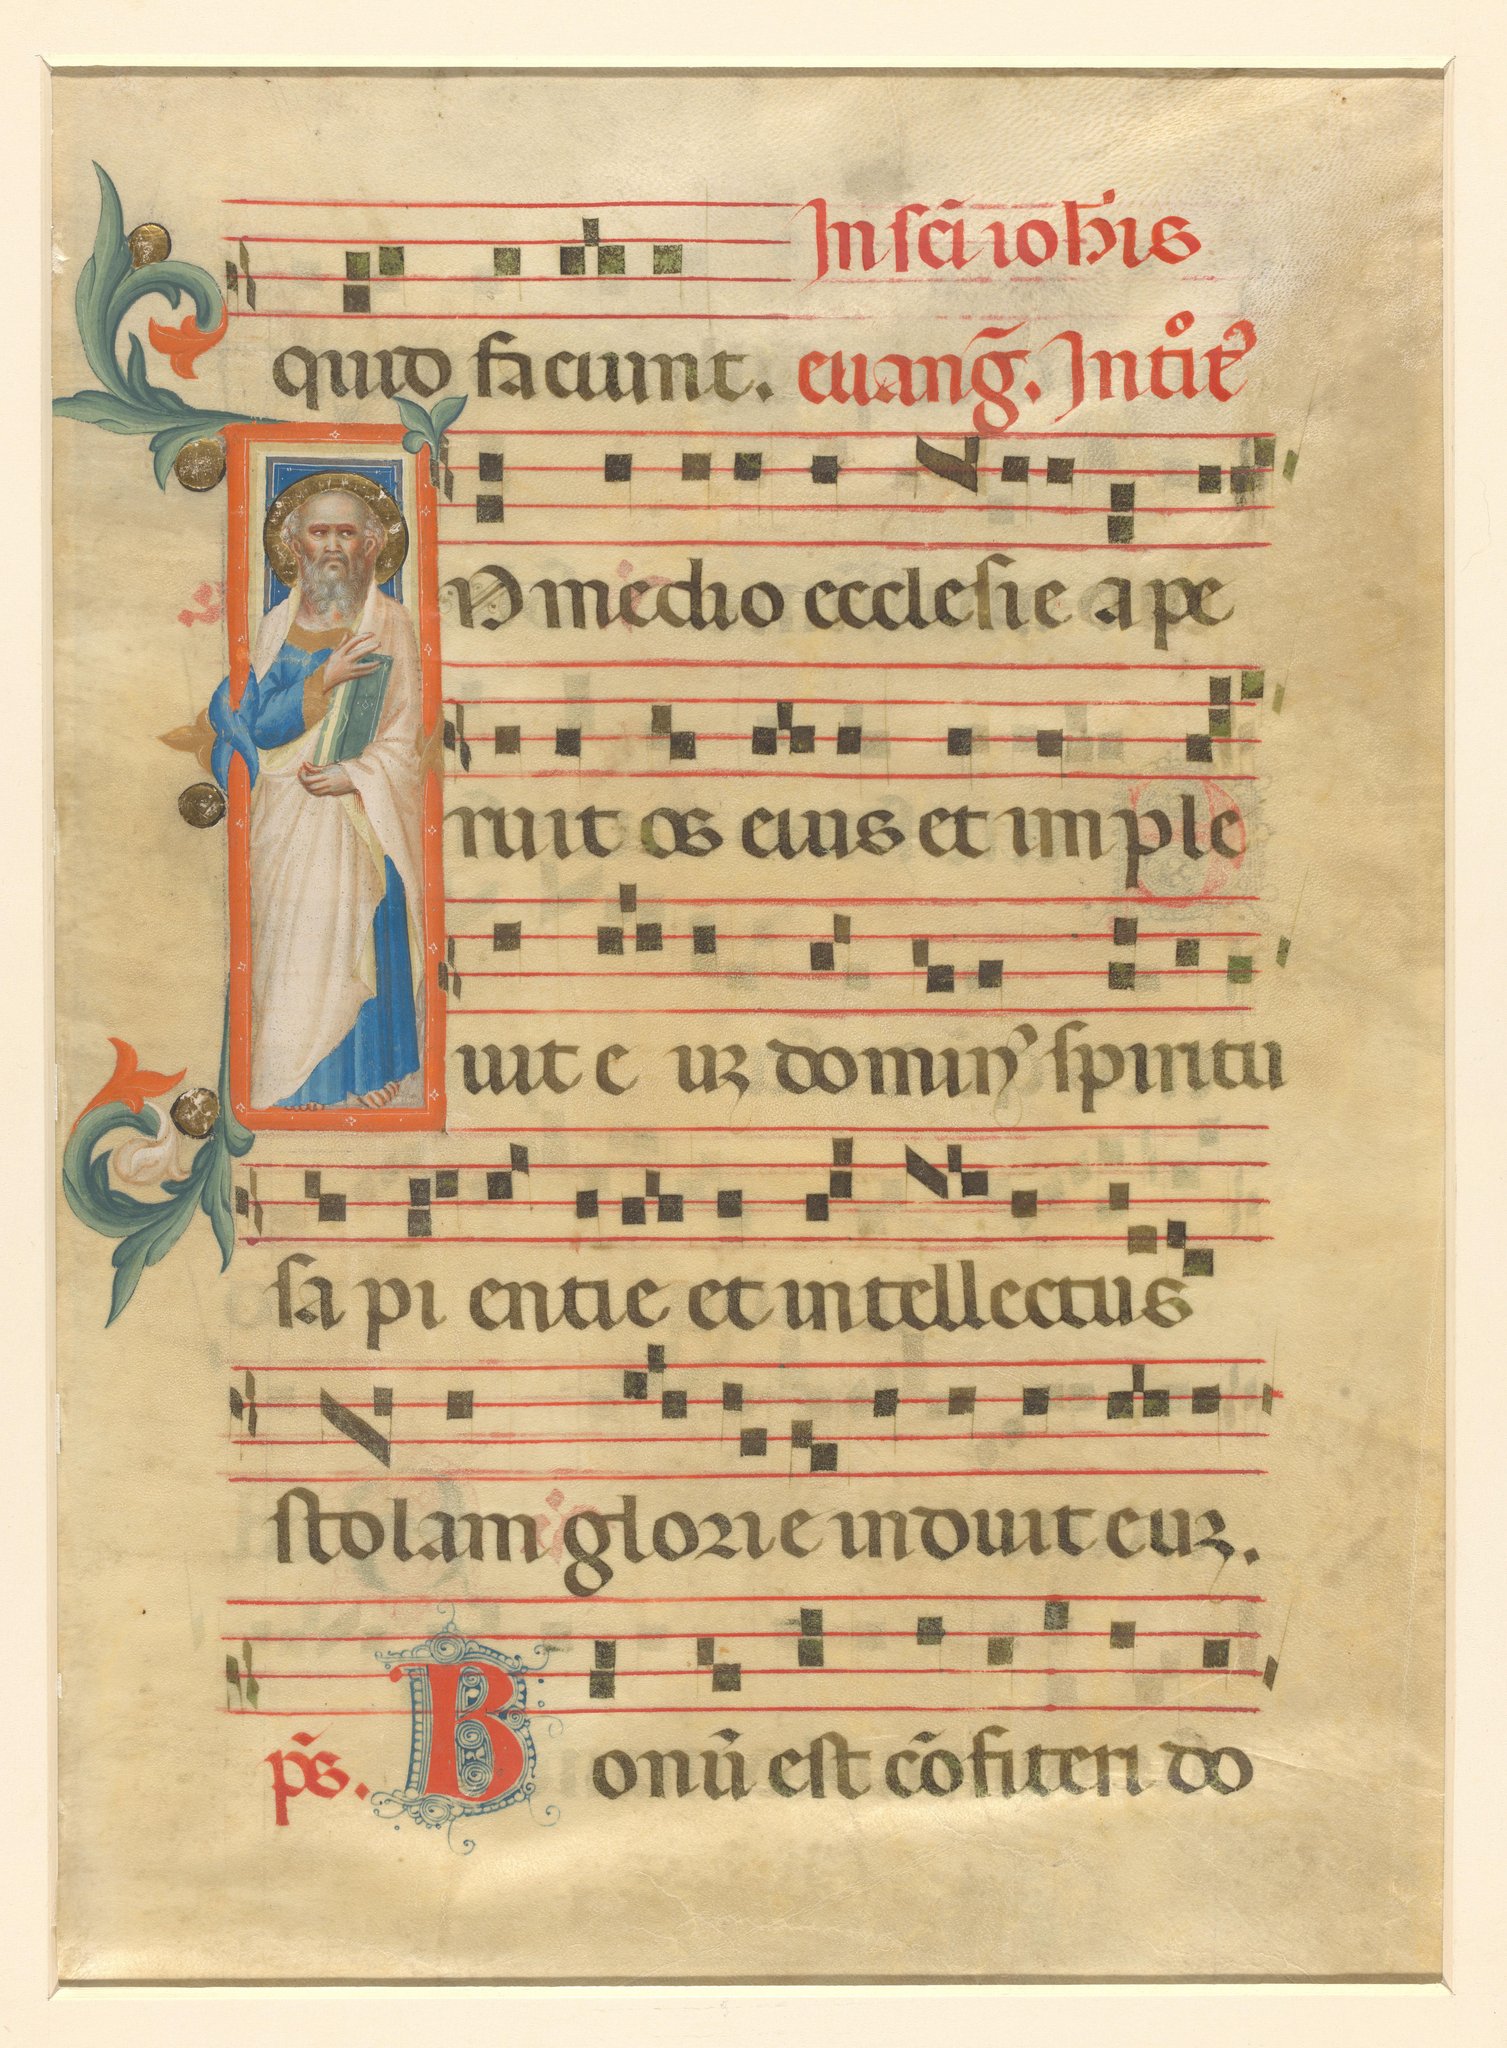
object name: miniature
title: Fragment van een missaal: initiaal met staande evangelist of apostel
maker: lippo vanni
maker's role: draughtsman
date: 1342-1346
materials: paint, gold leaf, ink, parchment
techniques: brush, pen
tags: saints, manuscript of musical score, historiated initial